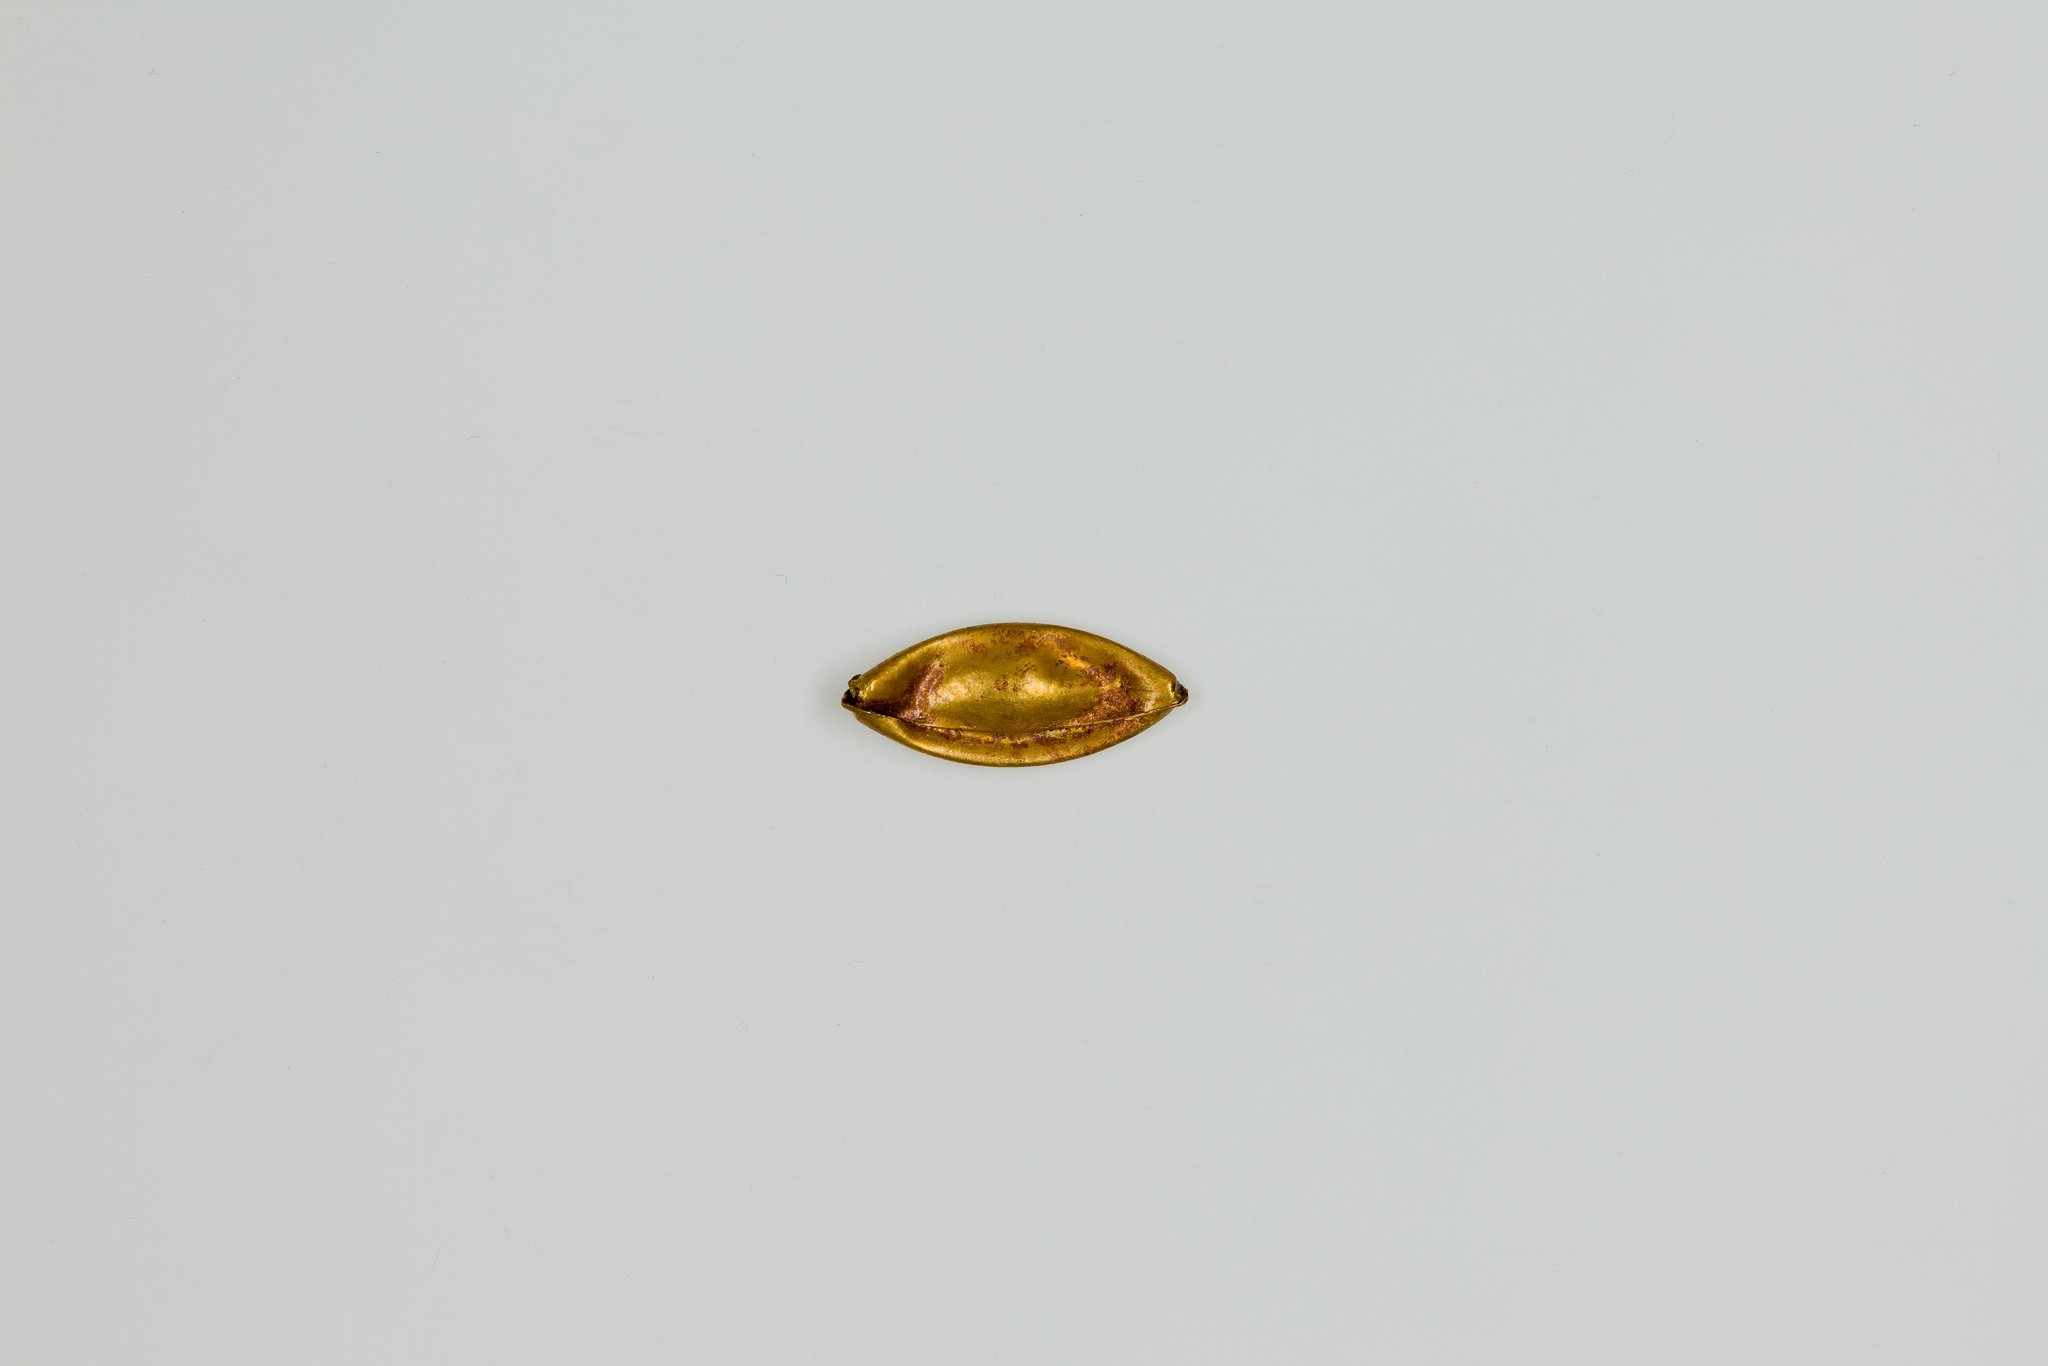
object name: cover for eye or belly button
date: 664-380 BCE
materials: gold